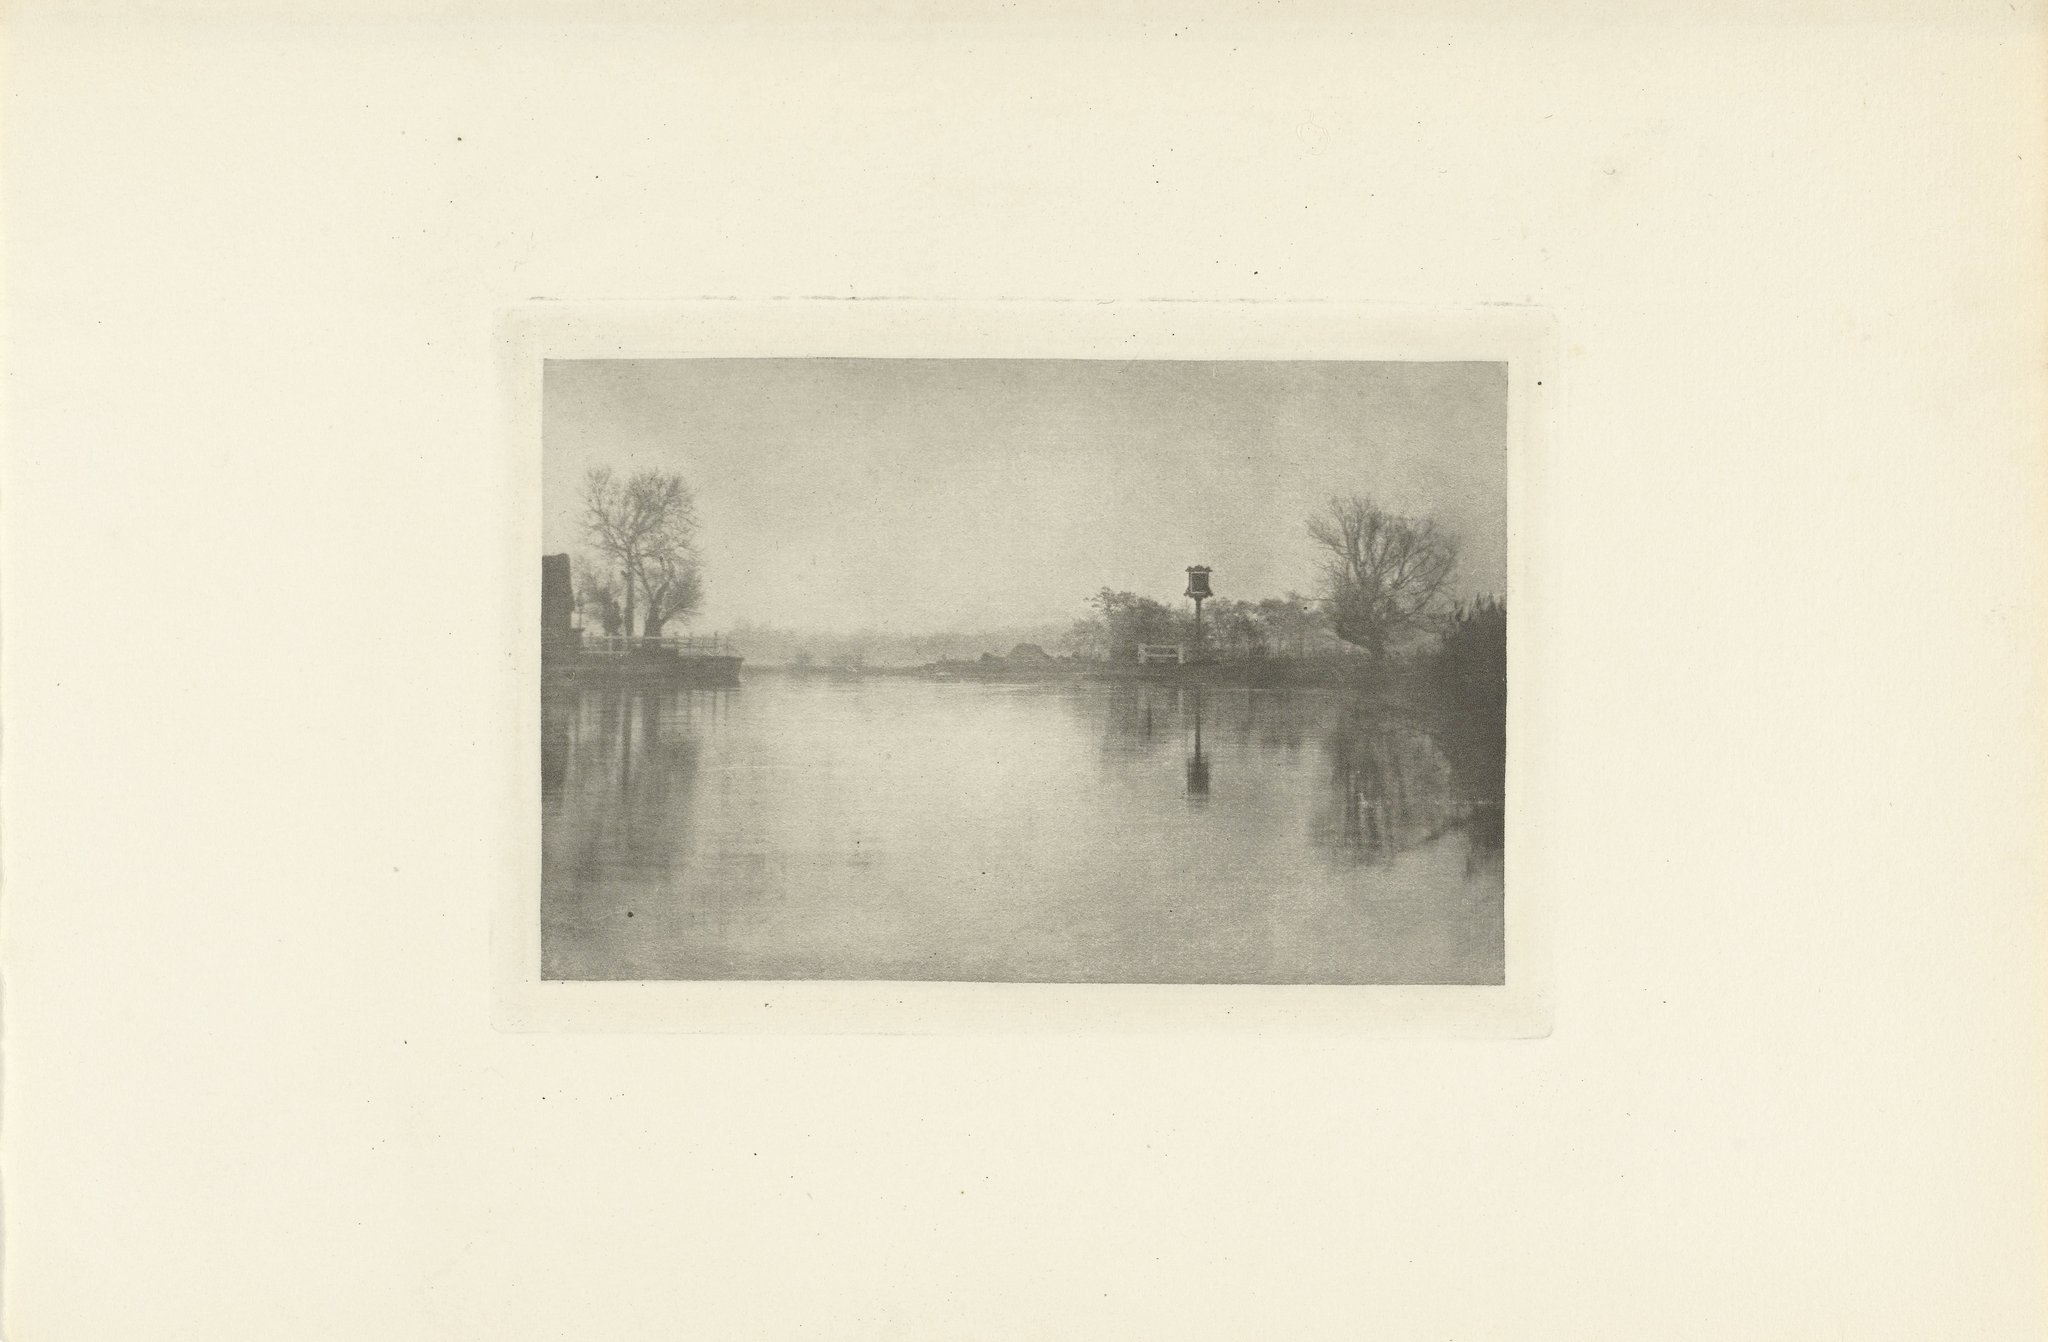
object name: photomechanical print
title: Marsh Leaves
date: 1890-1895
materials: paper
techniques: photoaquatint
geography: great britain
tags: river, great britain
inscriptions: inscription: ‘PLATE IV/ A WATERSIDE INN/ To face page 34’